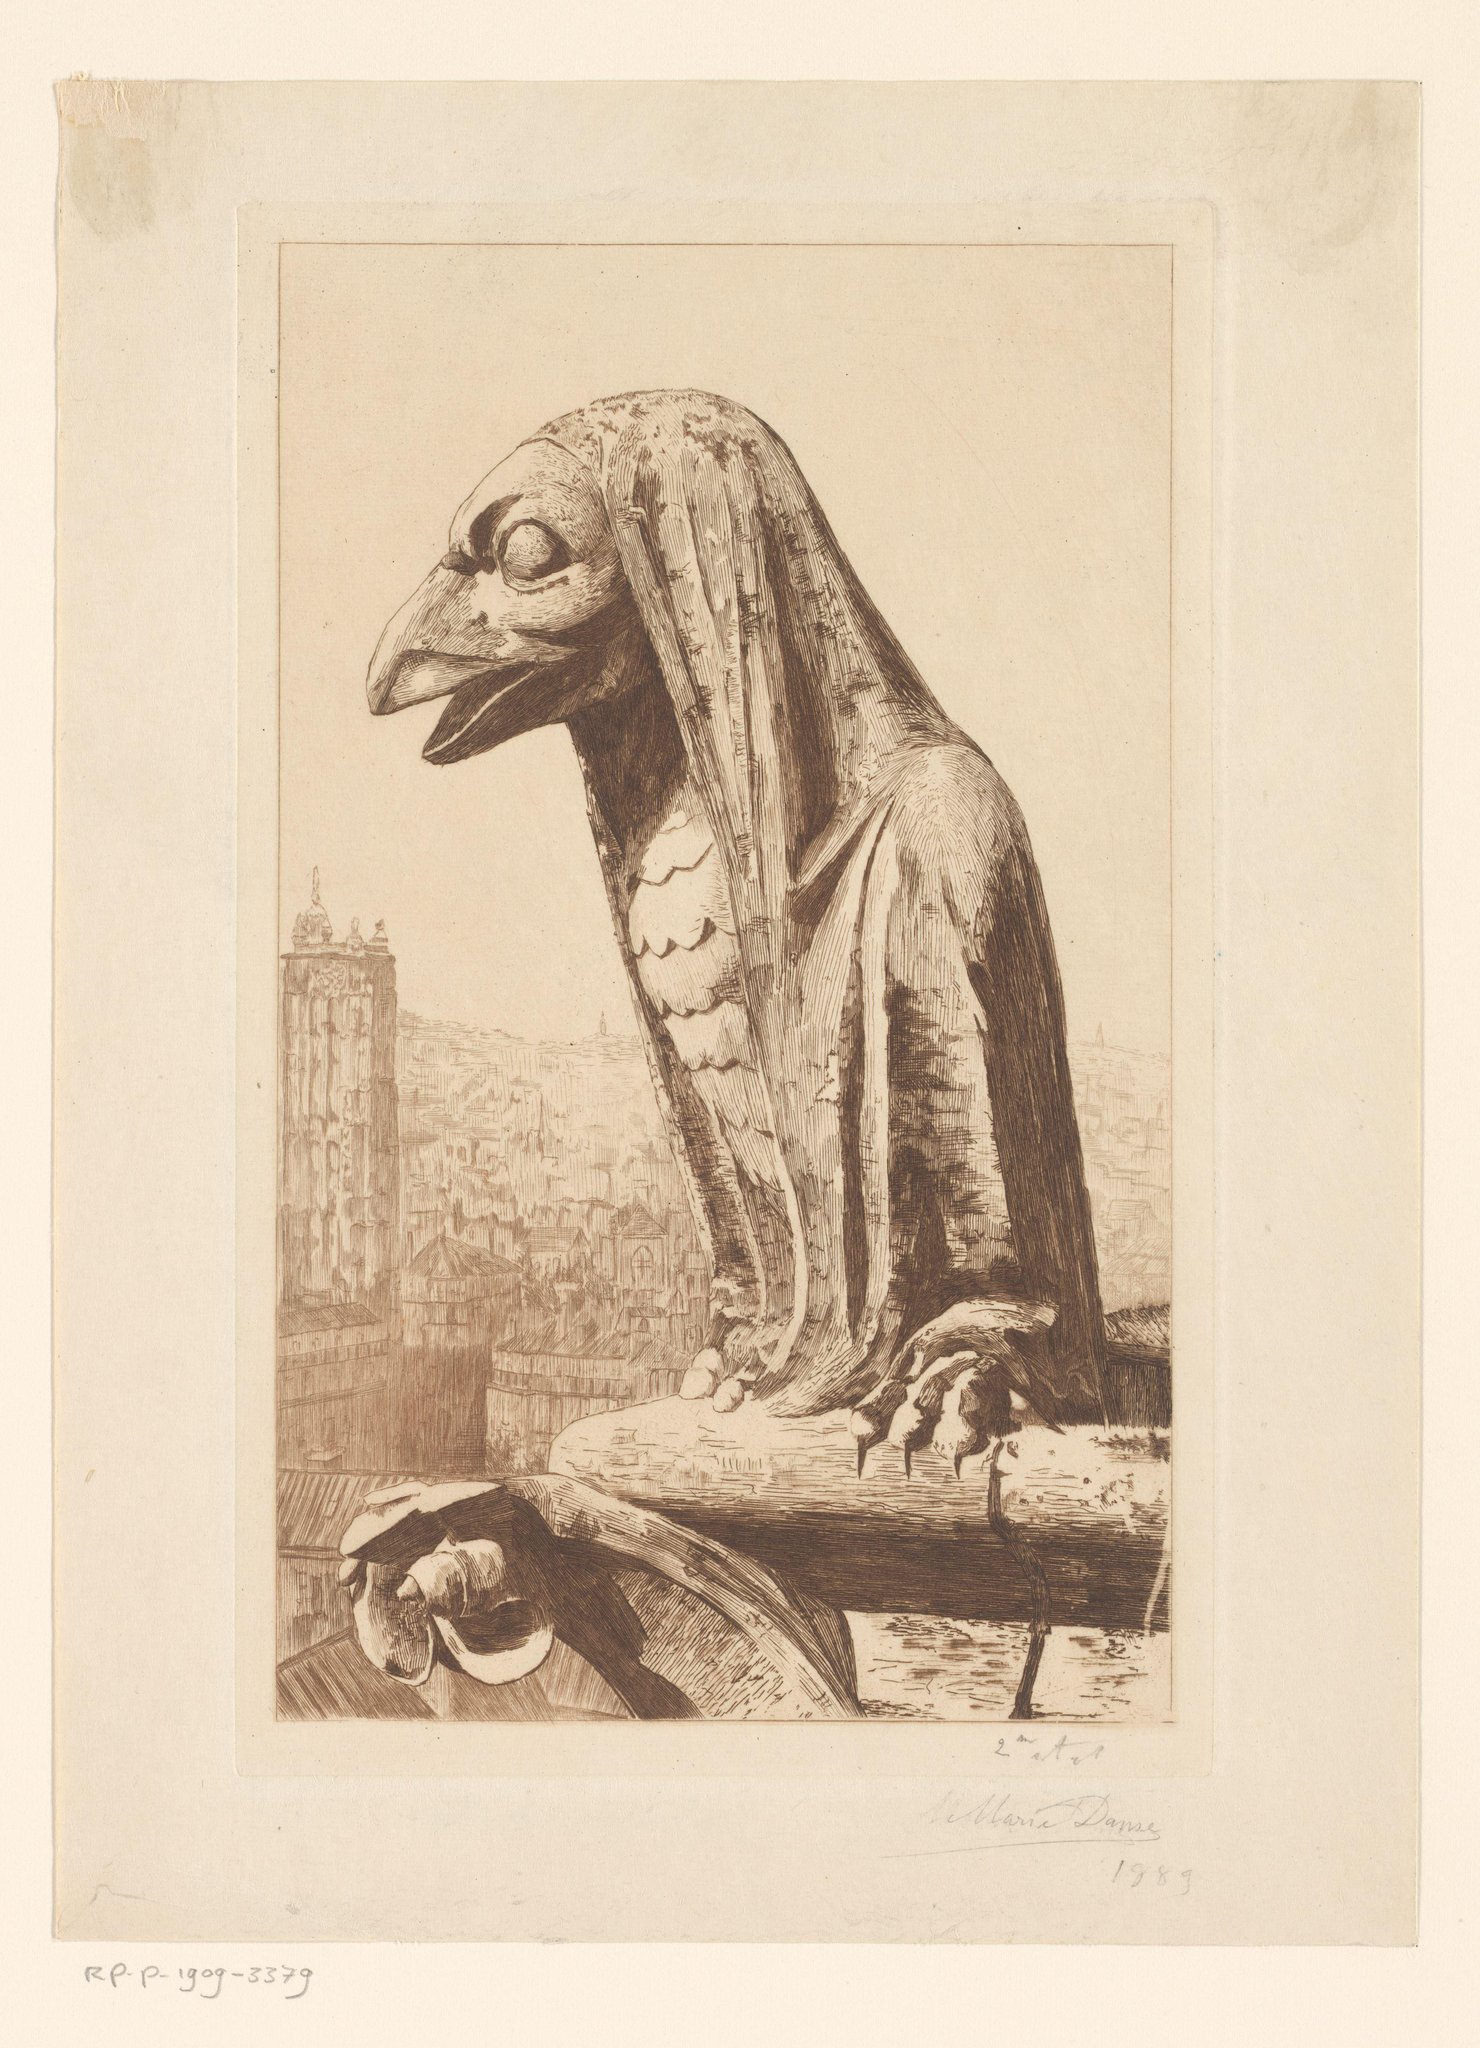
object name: print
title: Waterspuwer van de Notre-Dame te Parijs in de vorm van een vogel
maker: marie danse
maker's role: print maker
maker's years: 1867-1942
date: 1889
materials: paper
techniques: drypoint, etching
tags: ornament ~ hybrid animals, piece of sculpture, reproduction of a piece of sculpture, parts of church exterior and annexes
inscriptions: collector's mark: Lugt 2228, inscription: ‘2m etat’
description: Op de achtergrond is de stad Parijs te zien.